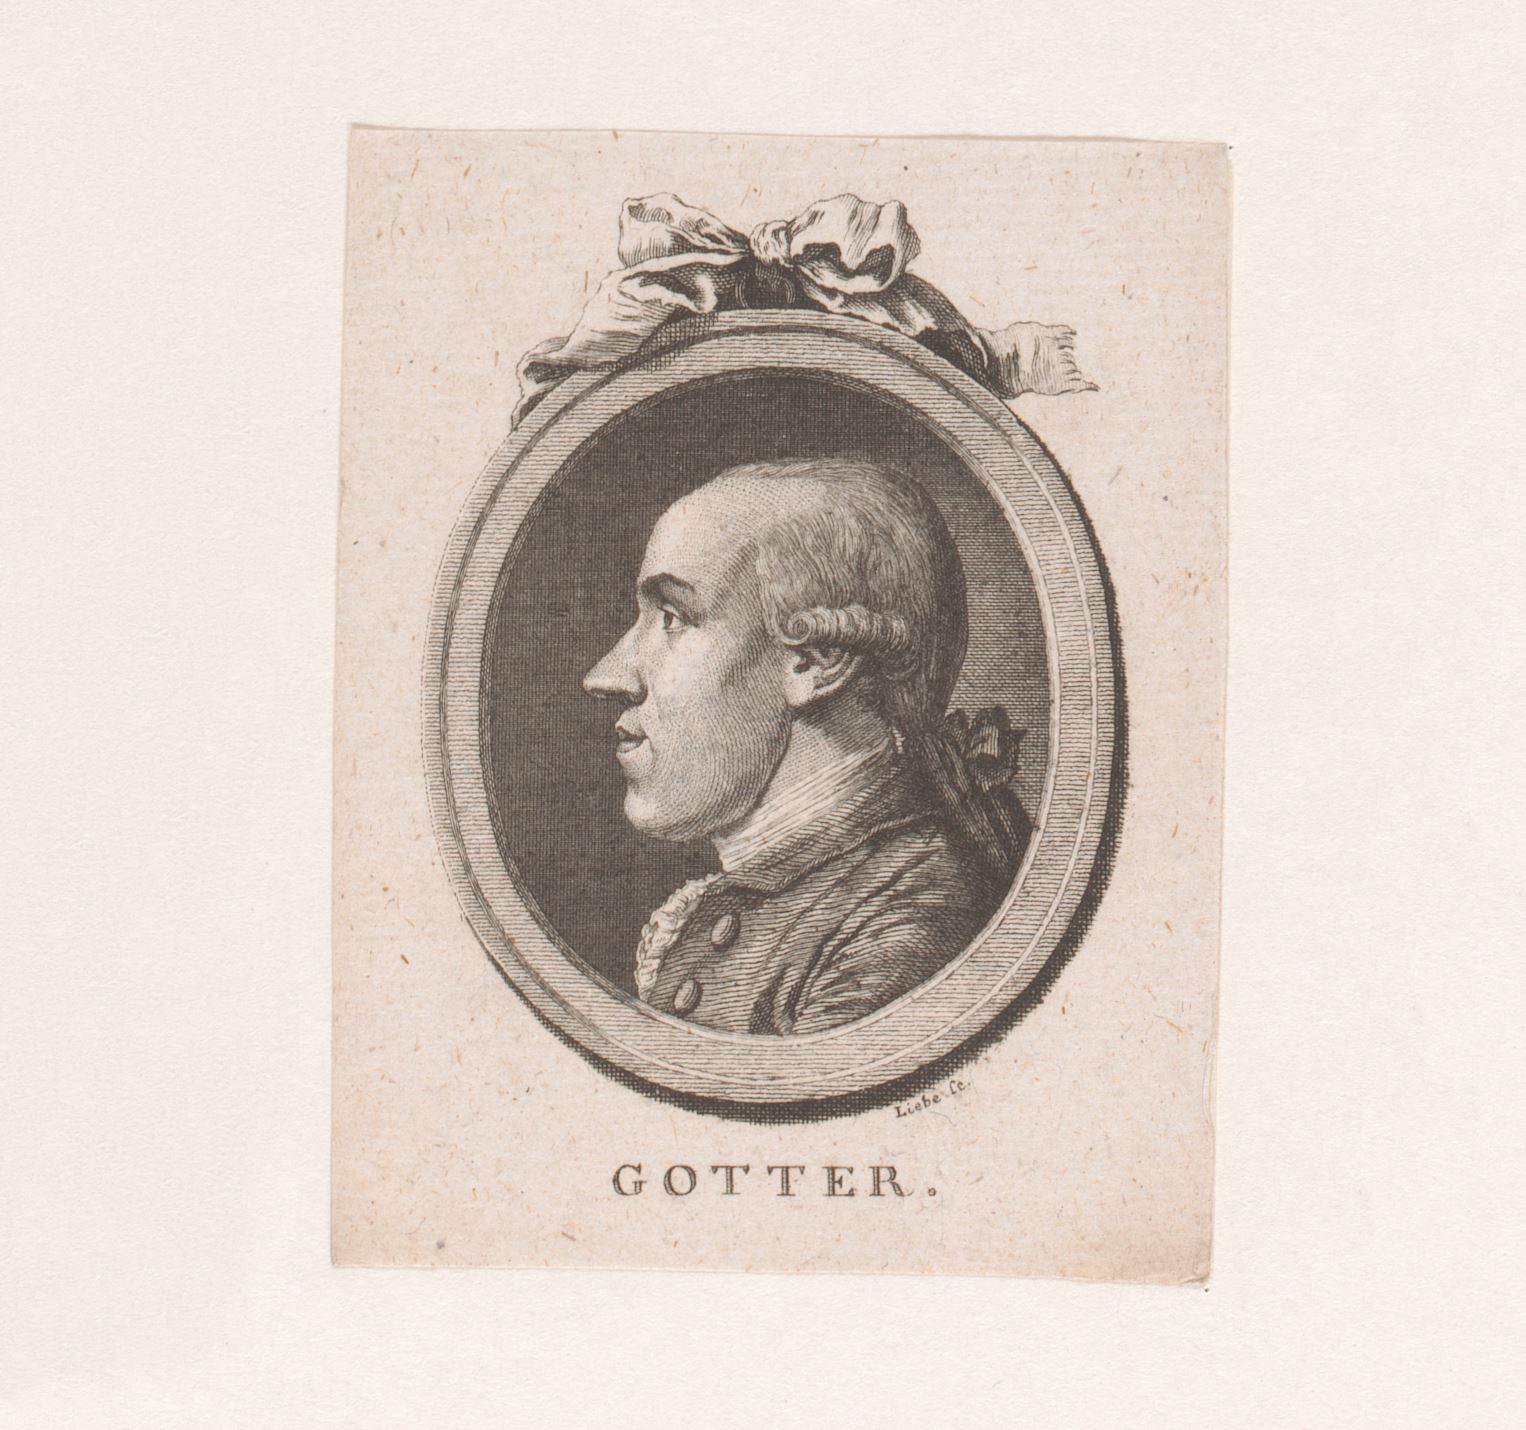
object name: print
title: Portret van Friedrich Wilhelm Gotter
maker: gottlob august liebe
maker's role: draughtsman, print maker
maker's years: 1746-1819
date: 1756-1819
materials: paper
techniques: engraving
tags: historical persons, writer, poet, author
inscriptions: collector's mark: Lugt 2228